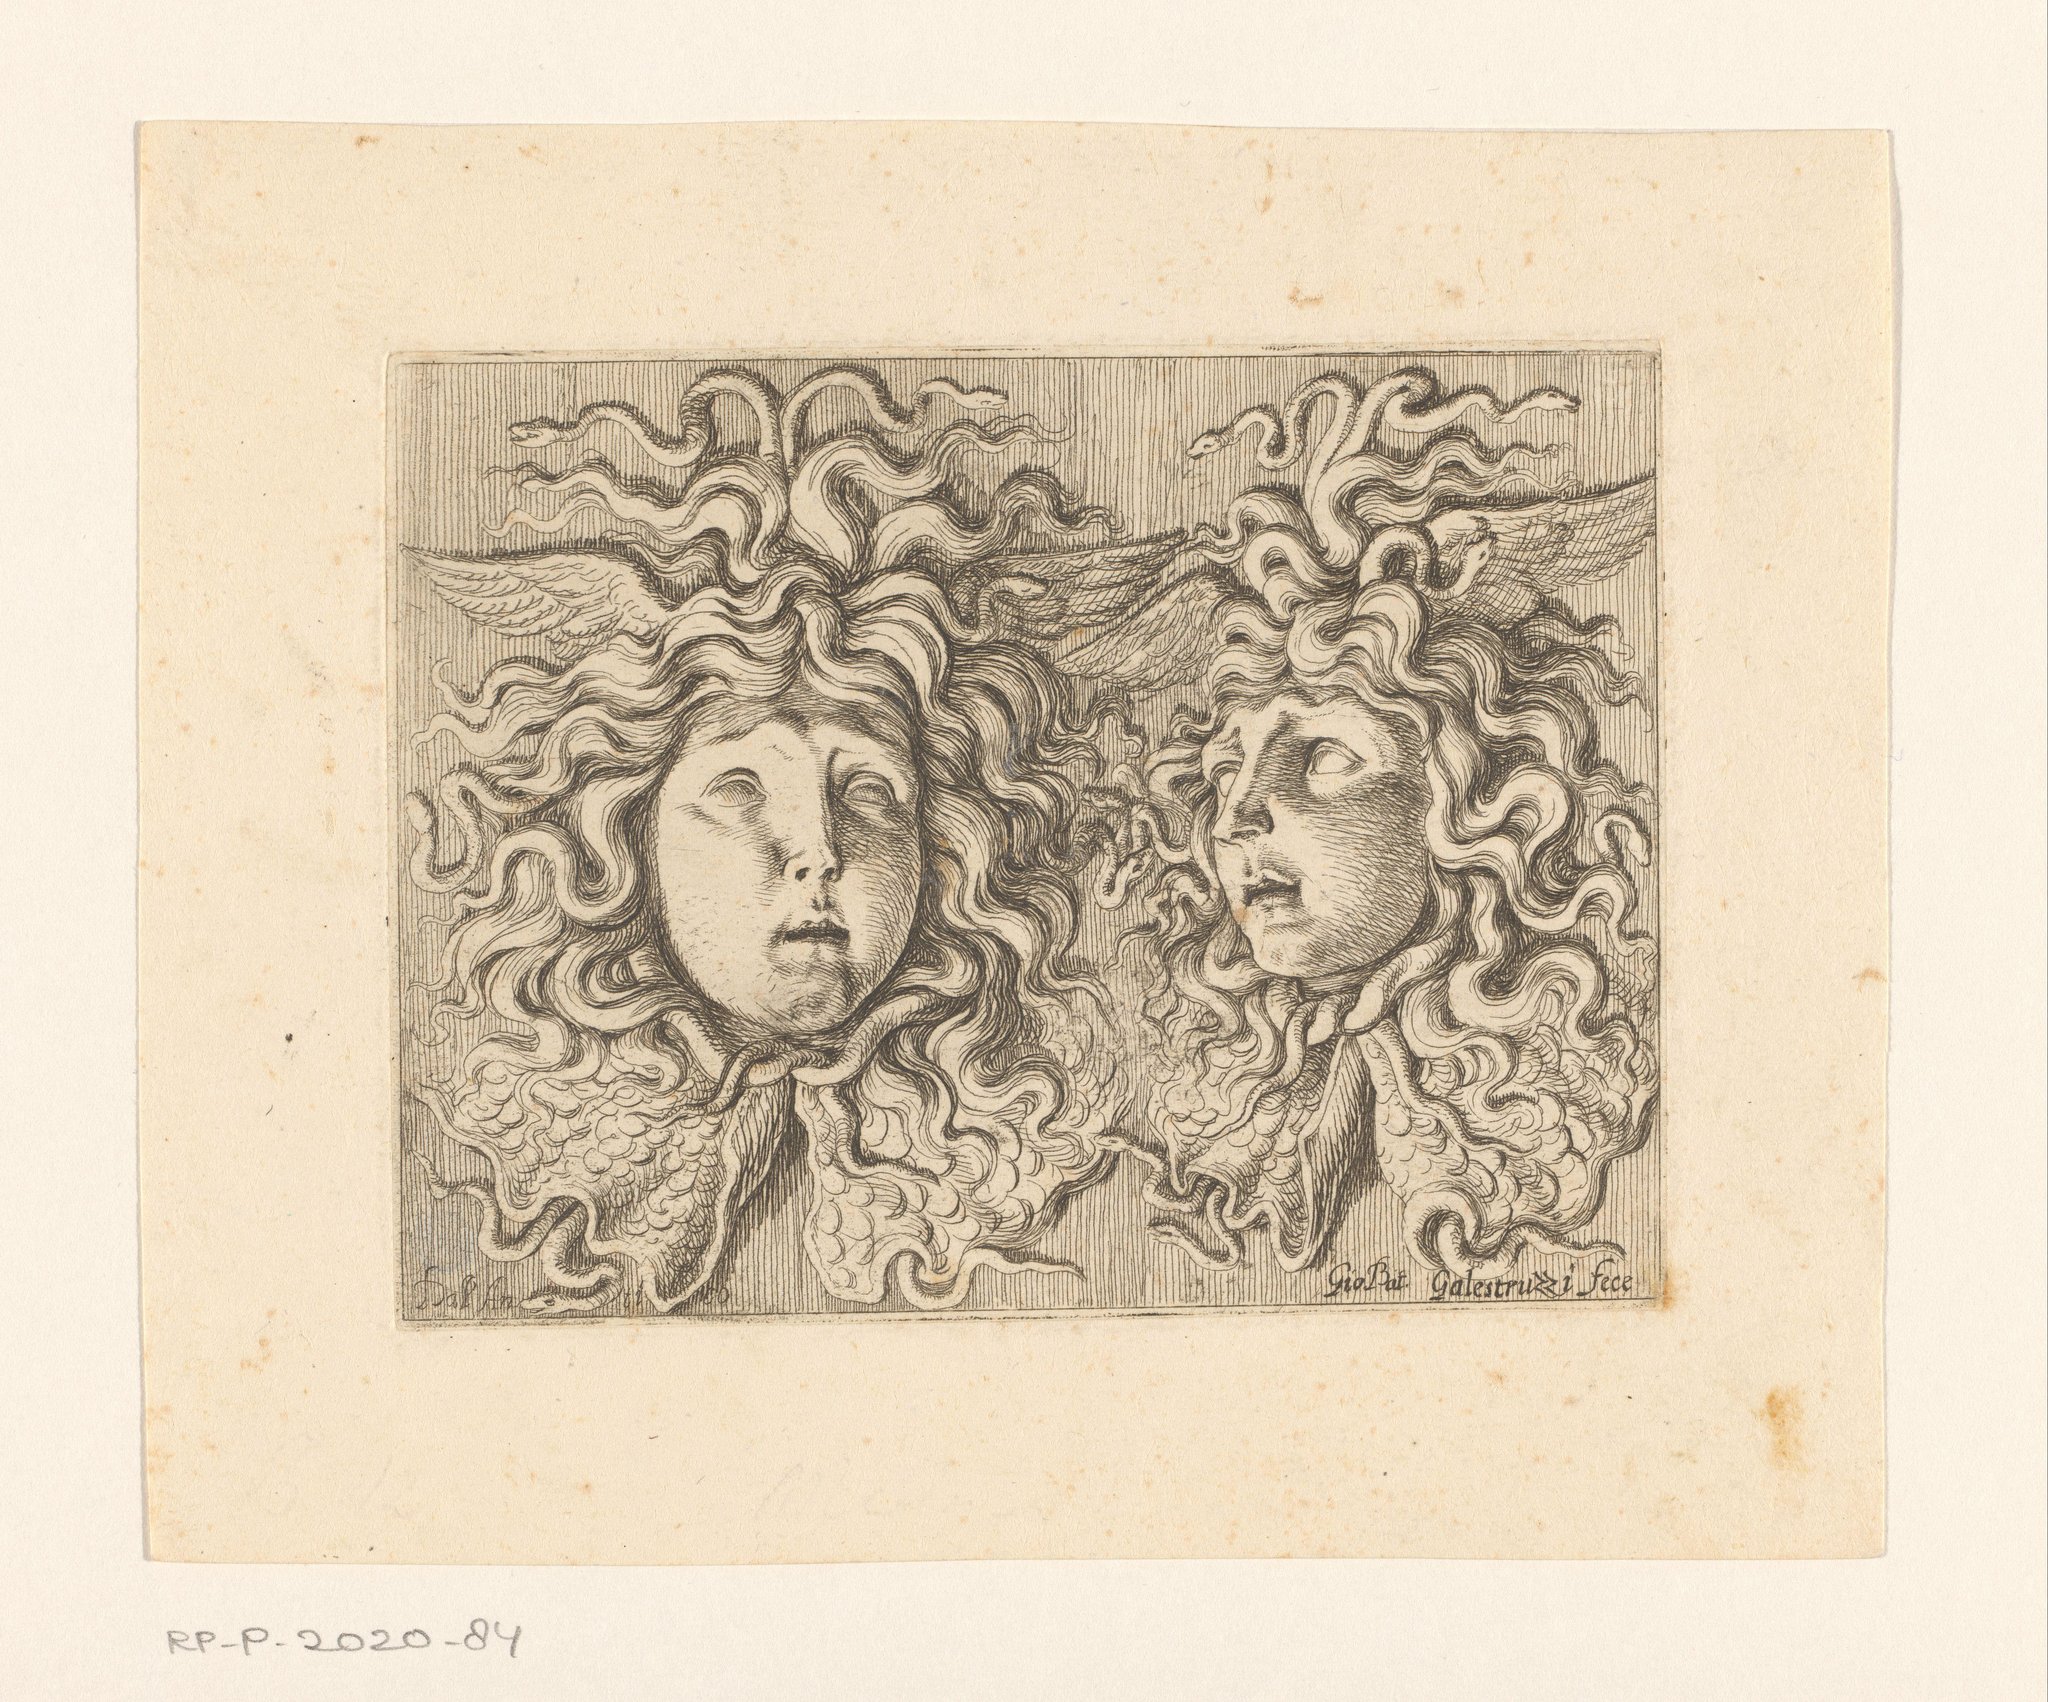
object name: print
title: Twee hoofden van Gorgonen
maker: giovanni battista galestruzzi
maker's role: painter, print maker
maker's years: 1618-1661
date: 1650-1670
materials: paper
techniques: etching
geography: italy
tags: gorgons, piece of sculpture, reproduction of a piece of sculpture, gorgoneion, head of medusa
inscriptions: collector's mark: Lugt 5100, collector's mark: Lugt 2760, collector's mark: Lugt 2228